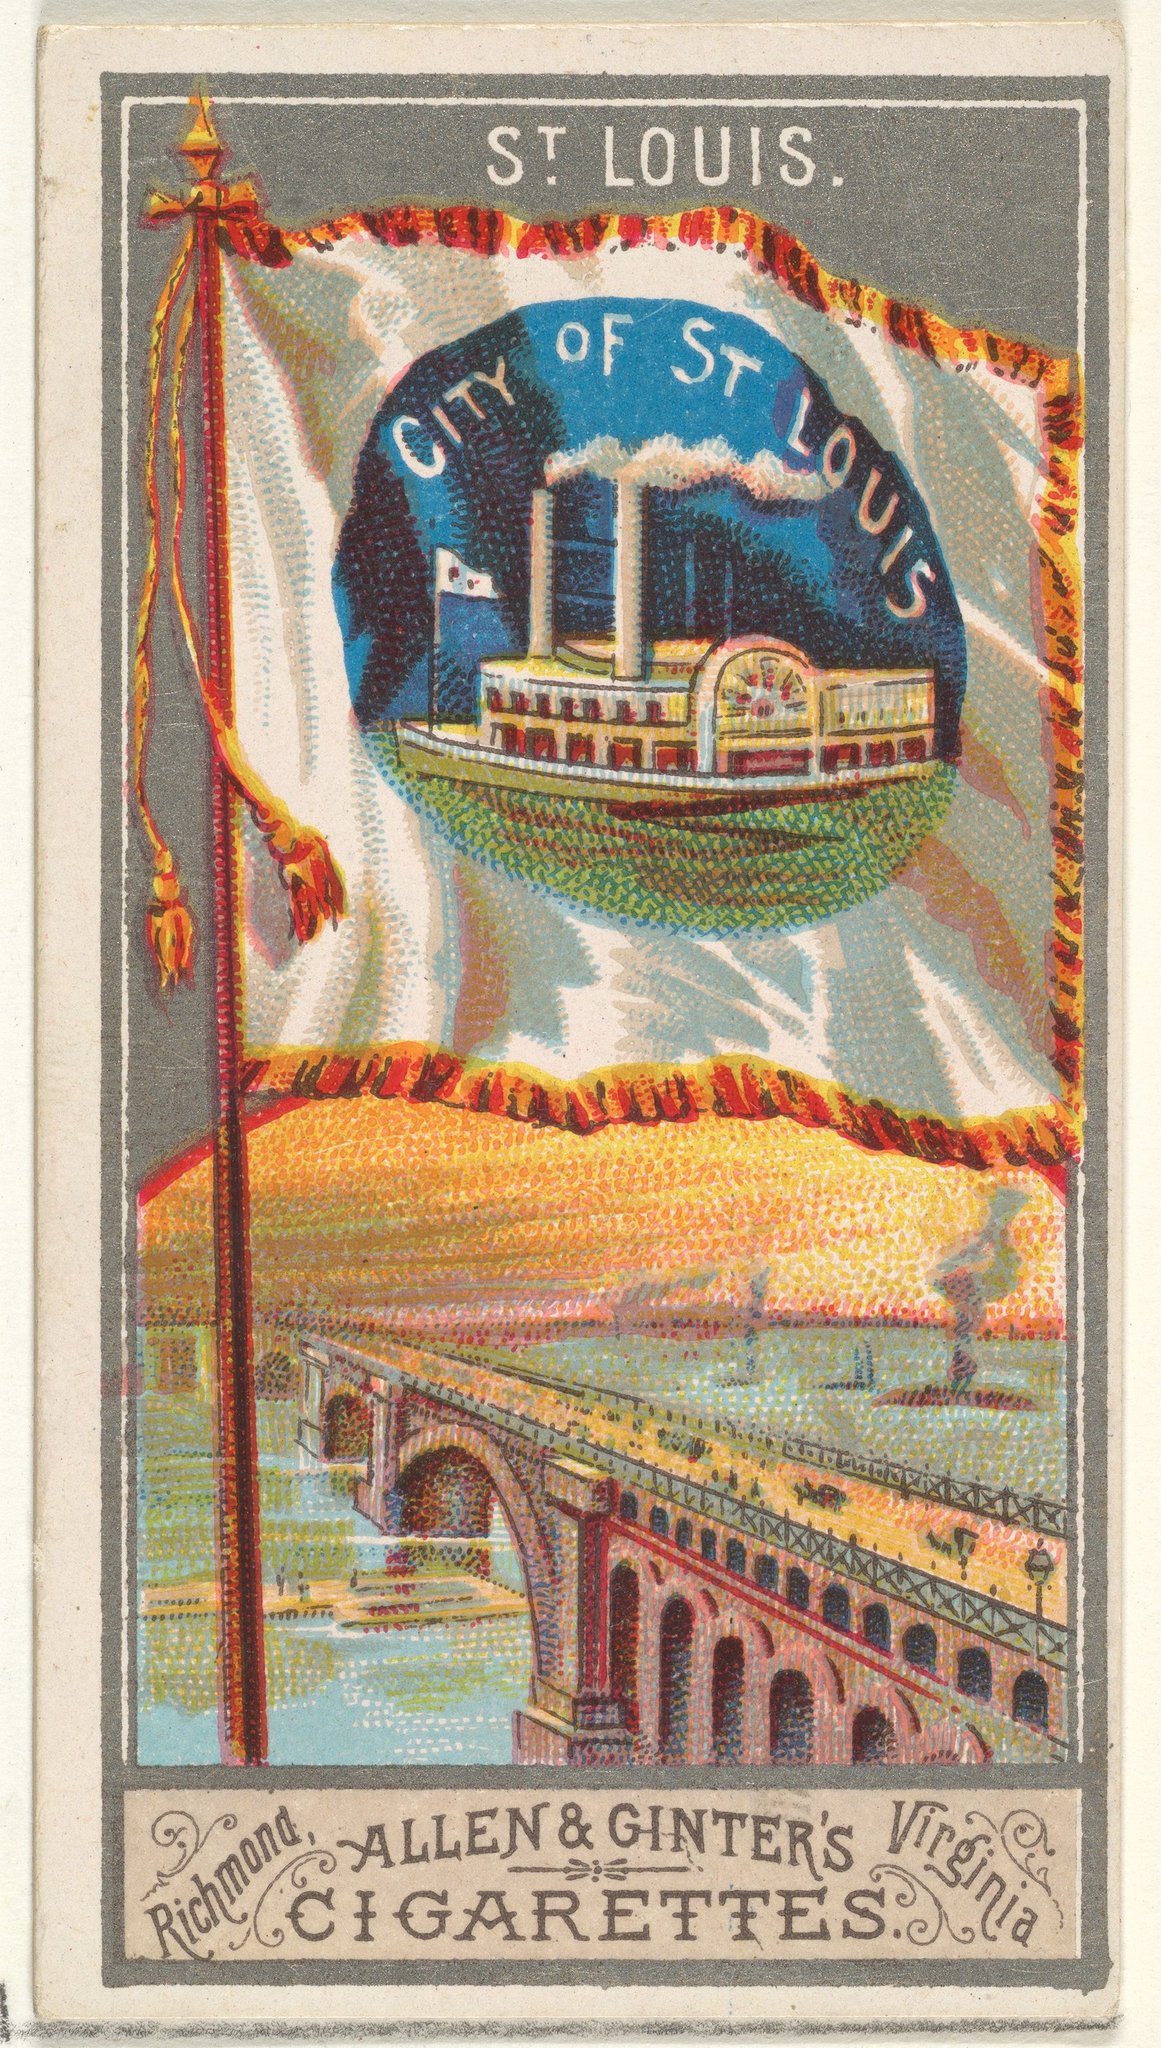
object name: print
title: St. Louis, from the City Flags series (N6) for Allen & Ginter Cigarettes Brands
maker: allen & ginter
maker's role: publisher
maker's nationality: american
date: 1887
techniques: color lithograph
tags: flags